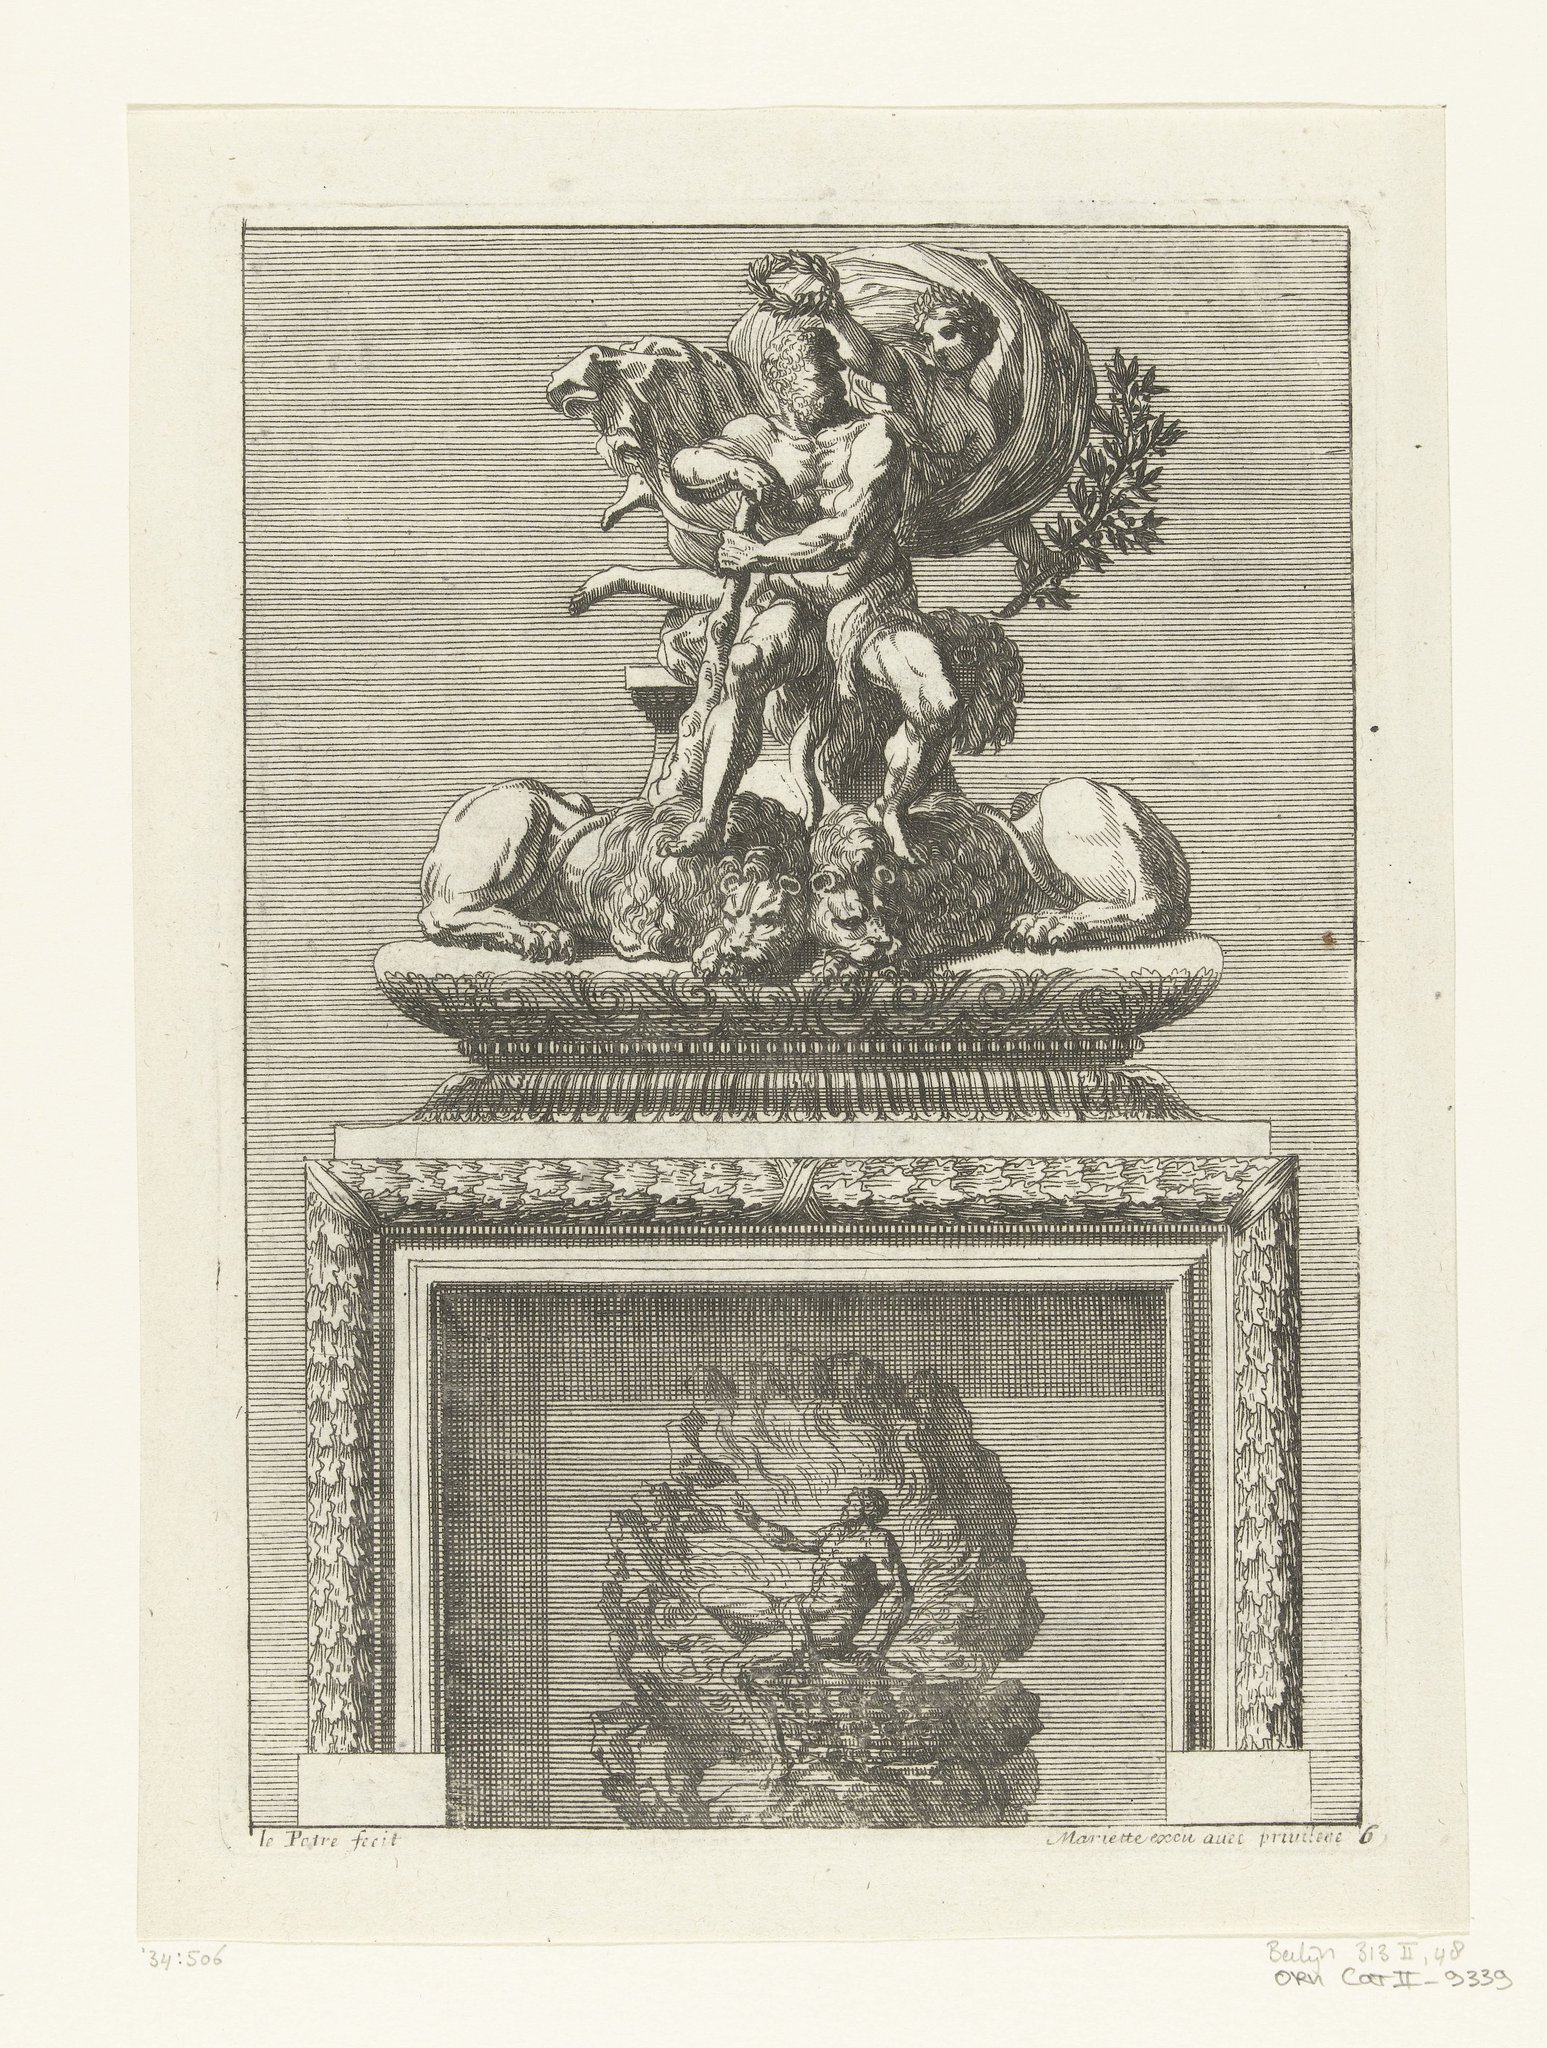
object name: print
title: Onderboezem met Hercules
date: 1661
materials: paper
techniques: etching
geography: france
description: Hercules wordt gekroond door een Victoriafiguur.